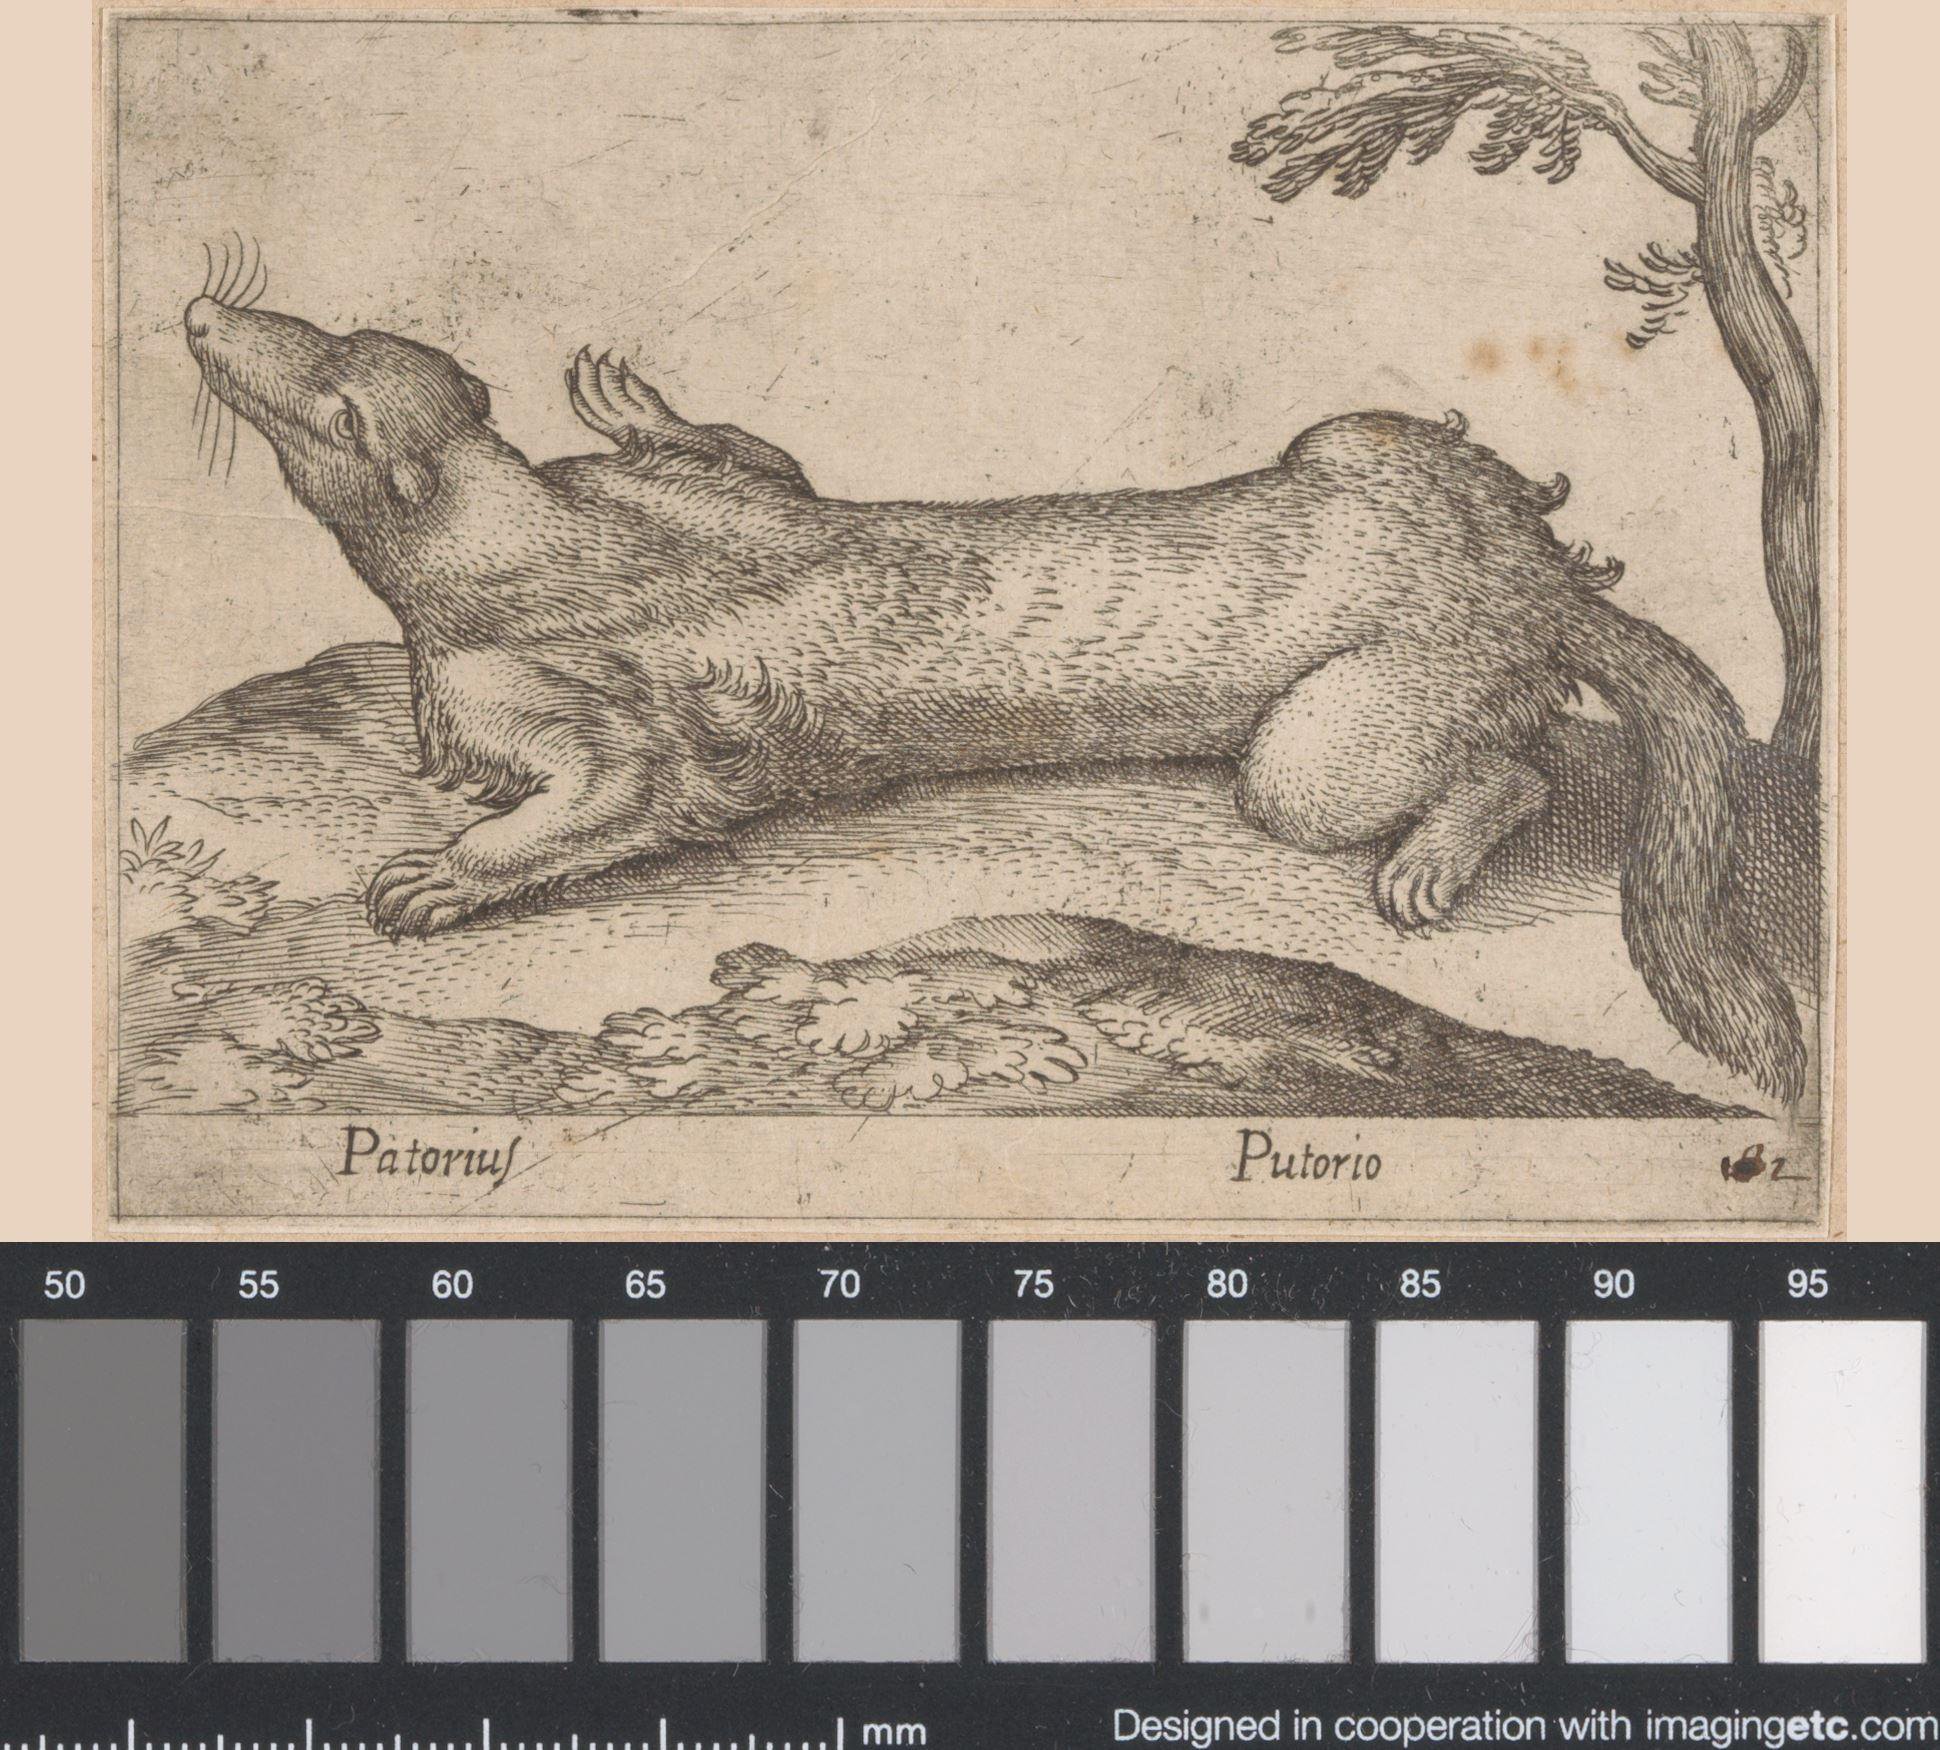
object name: print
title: Patorius/ Putorio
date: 1565-1630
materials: paper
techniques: etching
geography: vatican city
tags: other mammals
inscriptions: number: ‘129’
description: Deze prent maakt deel uit van een reeks prenten van dieren door Antonio Tempesta. Bekend is dat een tweede staat (met nummering) van deze serie is uitgegeven door Giovanni Giacomo de' Rossi in 1650. Onbekend is wie de eerste staat heeft uitgegeven en wanneer.